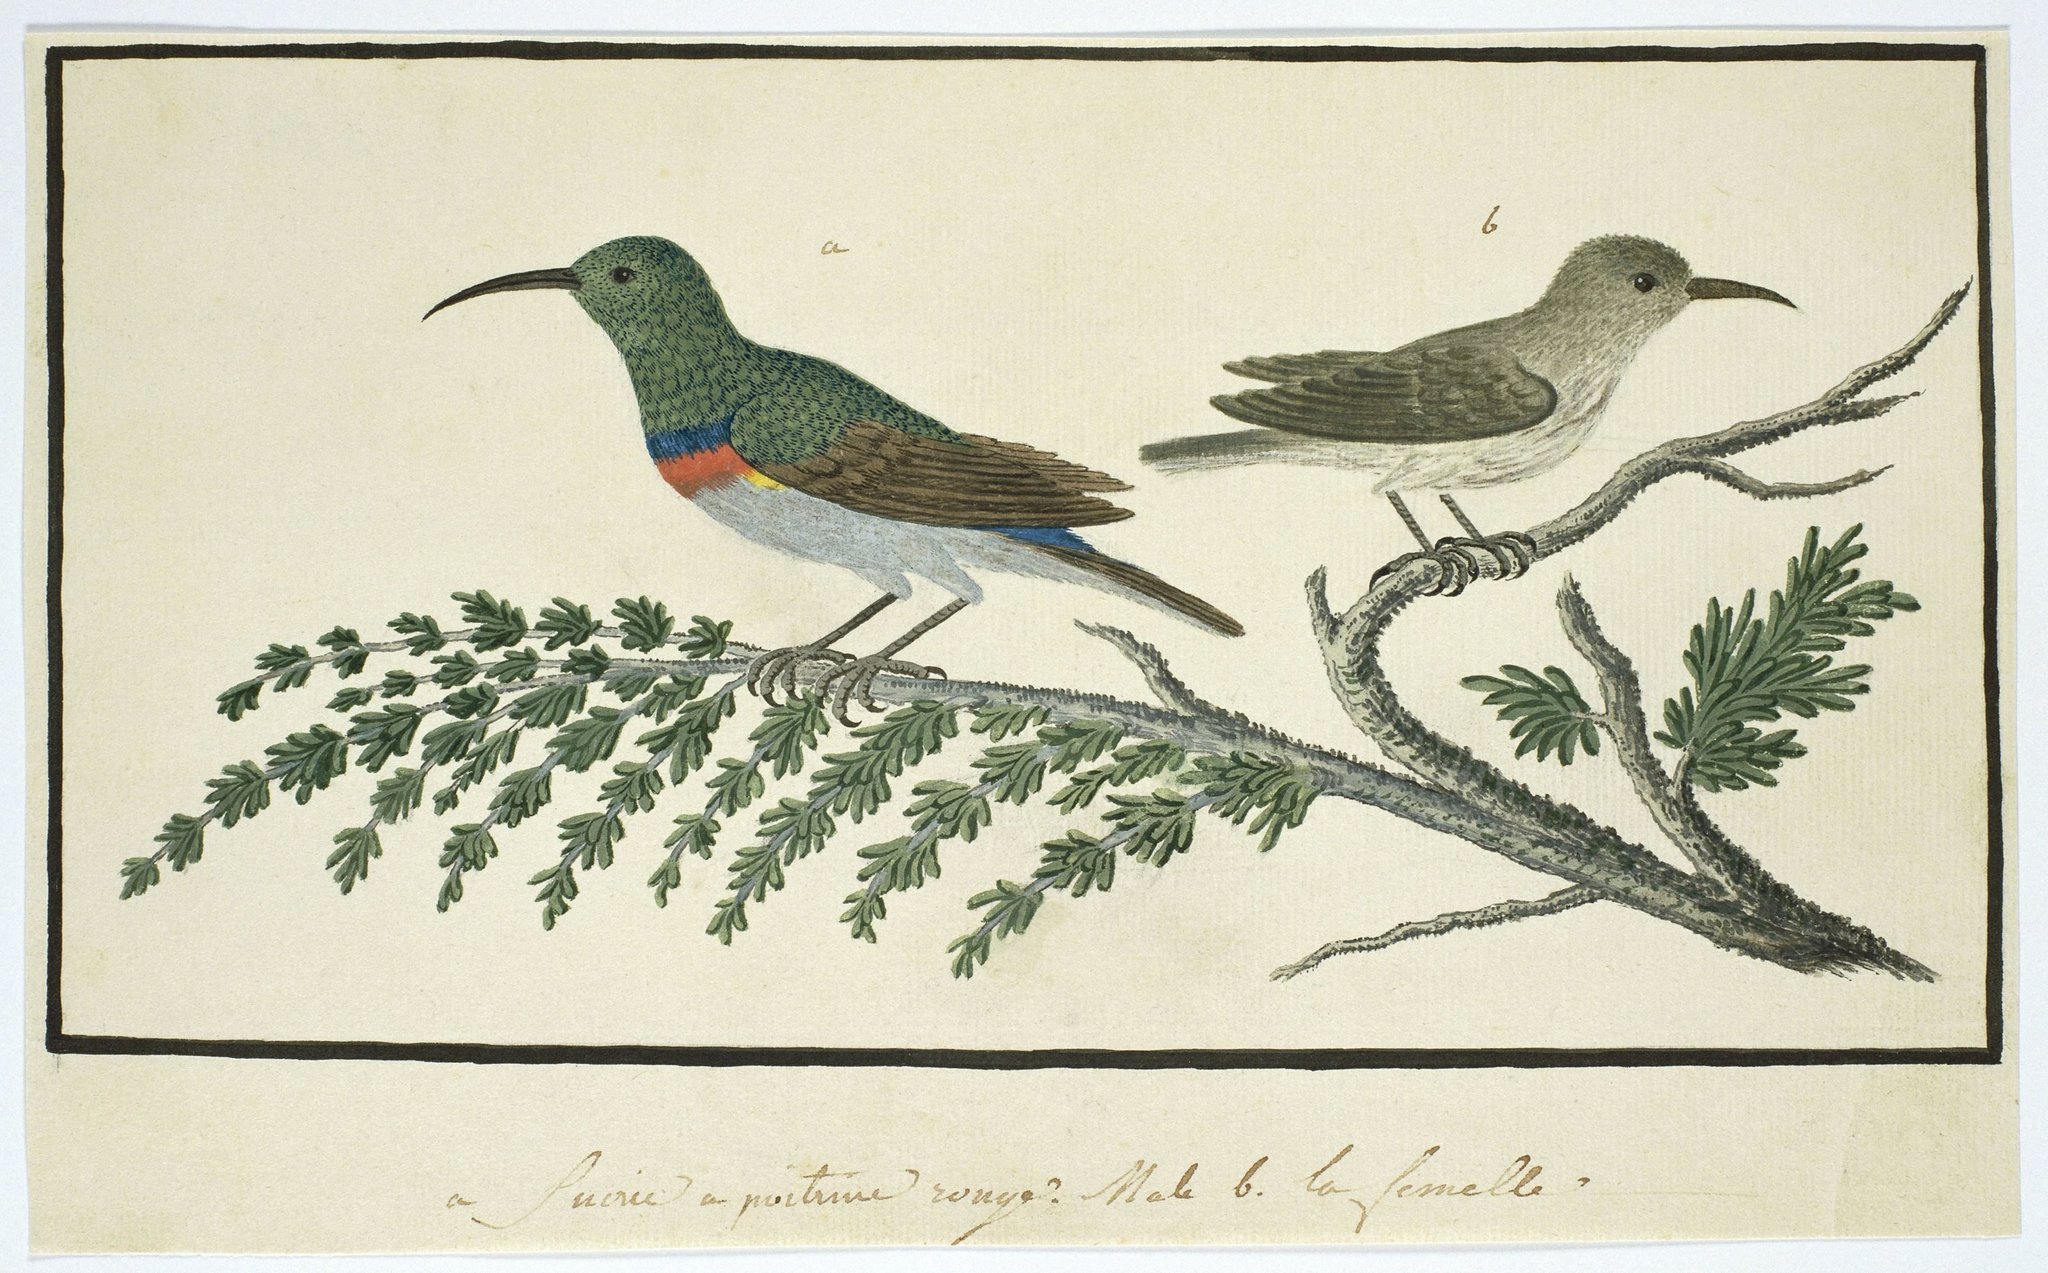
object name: drawing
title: Nectarinia afra (Greater double-collared sunbird)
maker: robert jacob gordon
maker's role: draughtsman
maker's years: 1743-1795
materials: paint, ink, paper, pencil, watercolor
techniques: brush, pen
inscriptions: annotation: ‘a. en b. (bij vogels); Sucrie a poitrine rouge. Male b. la femelle’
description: Greater double-collared sunbird (Eng.). Ned. naam uit een boek over de fauna van Zuidelijk Afrika (EvK). Franse benaming geschreven door Levaillant.